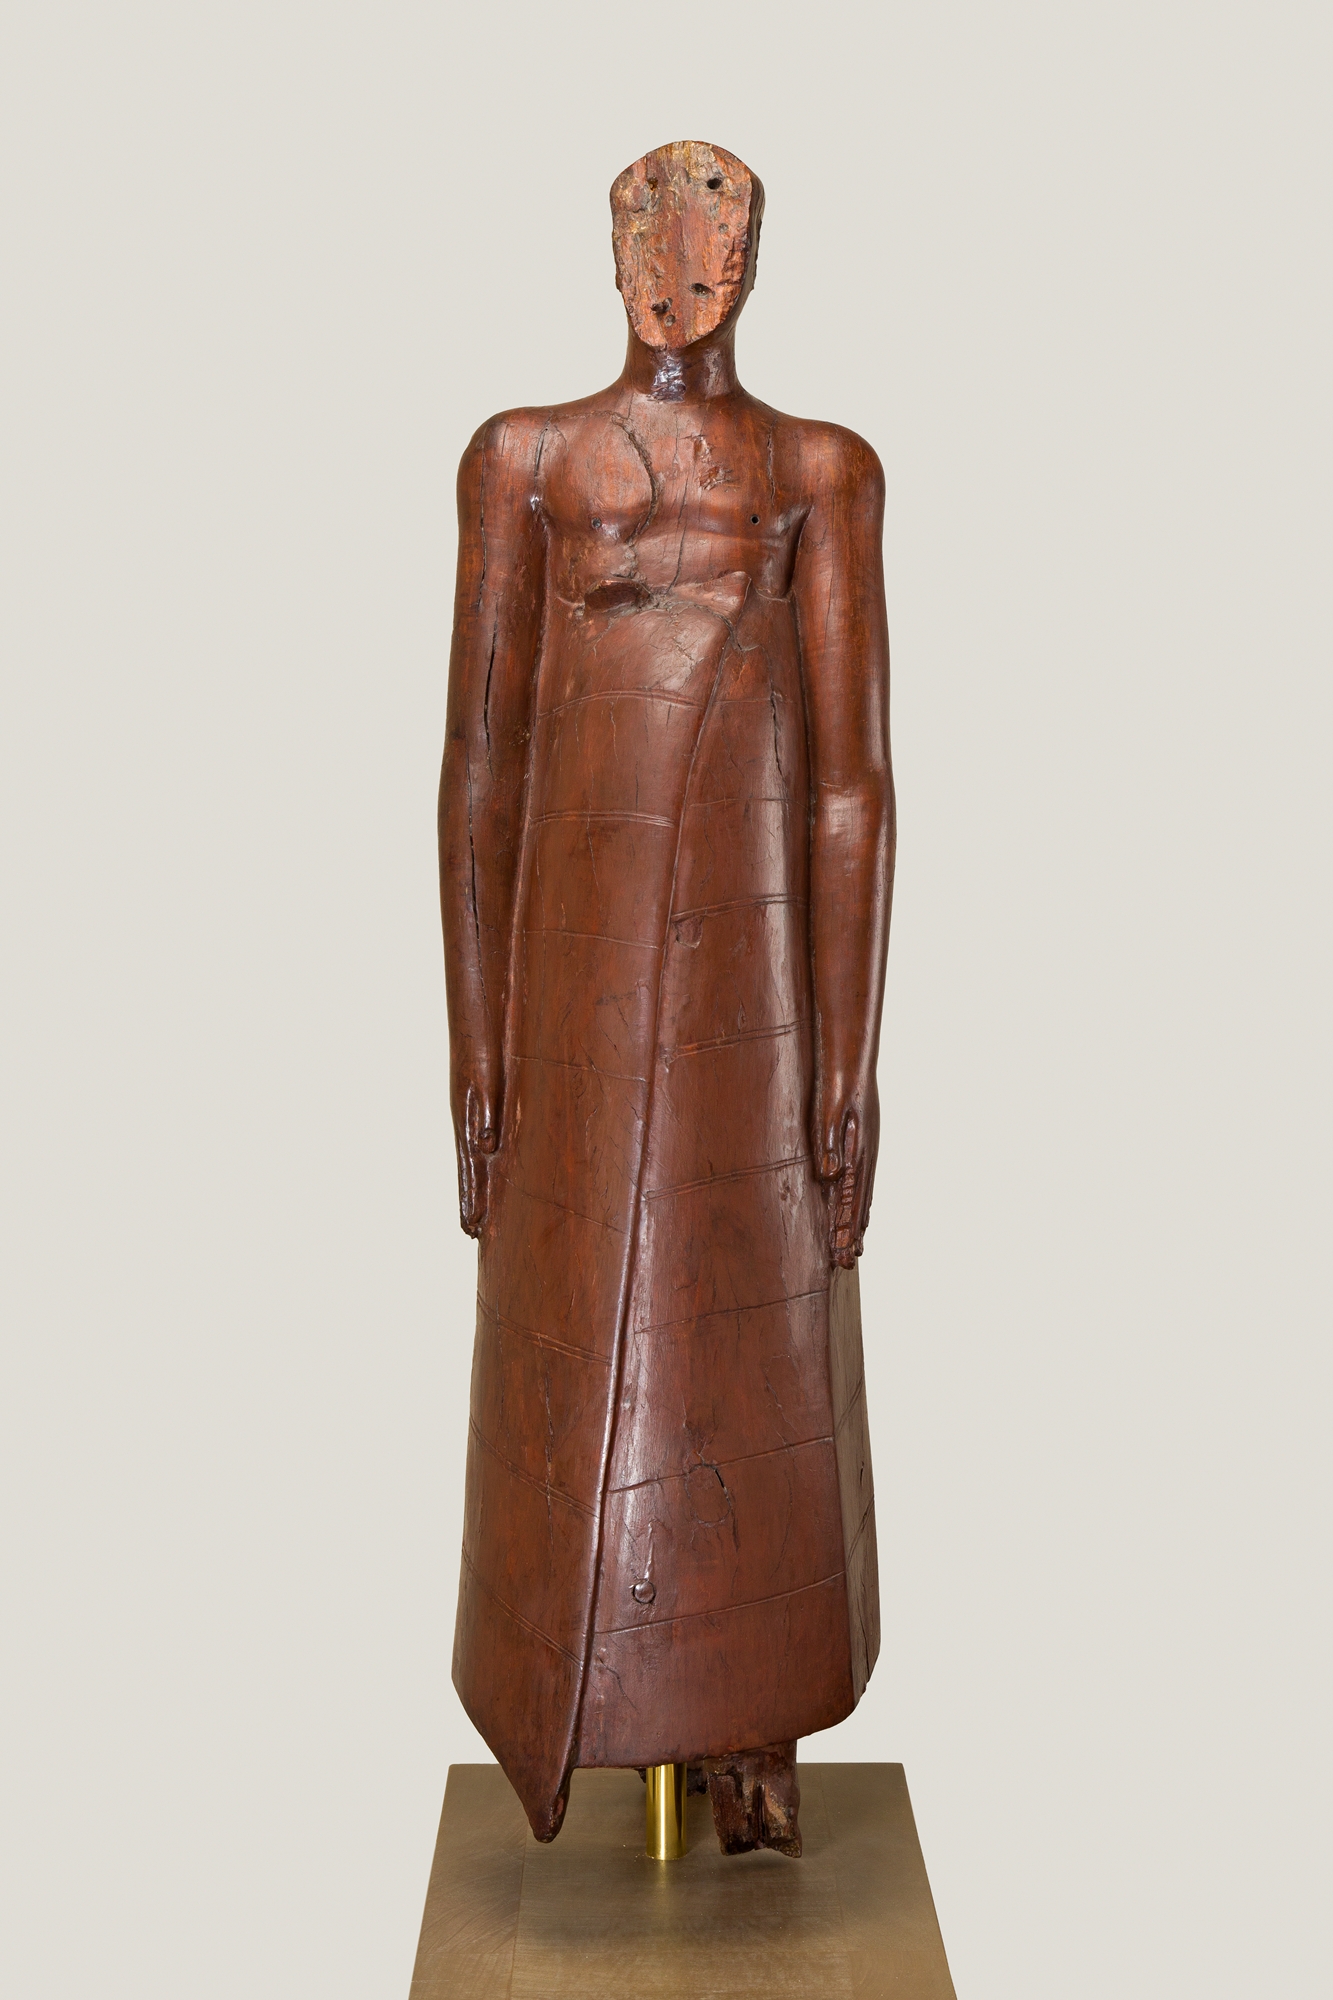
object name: statue, vizier iuy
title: Statue of the Vizier Iuy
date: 1700 BCE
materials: wood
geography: egypt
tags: men